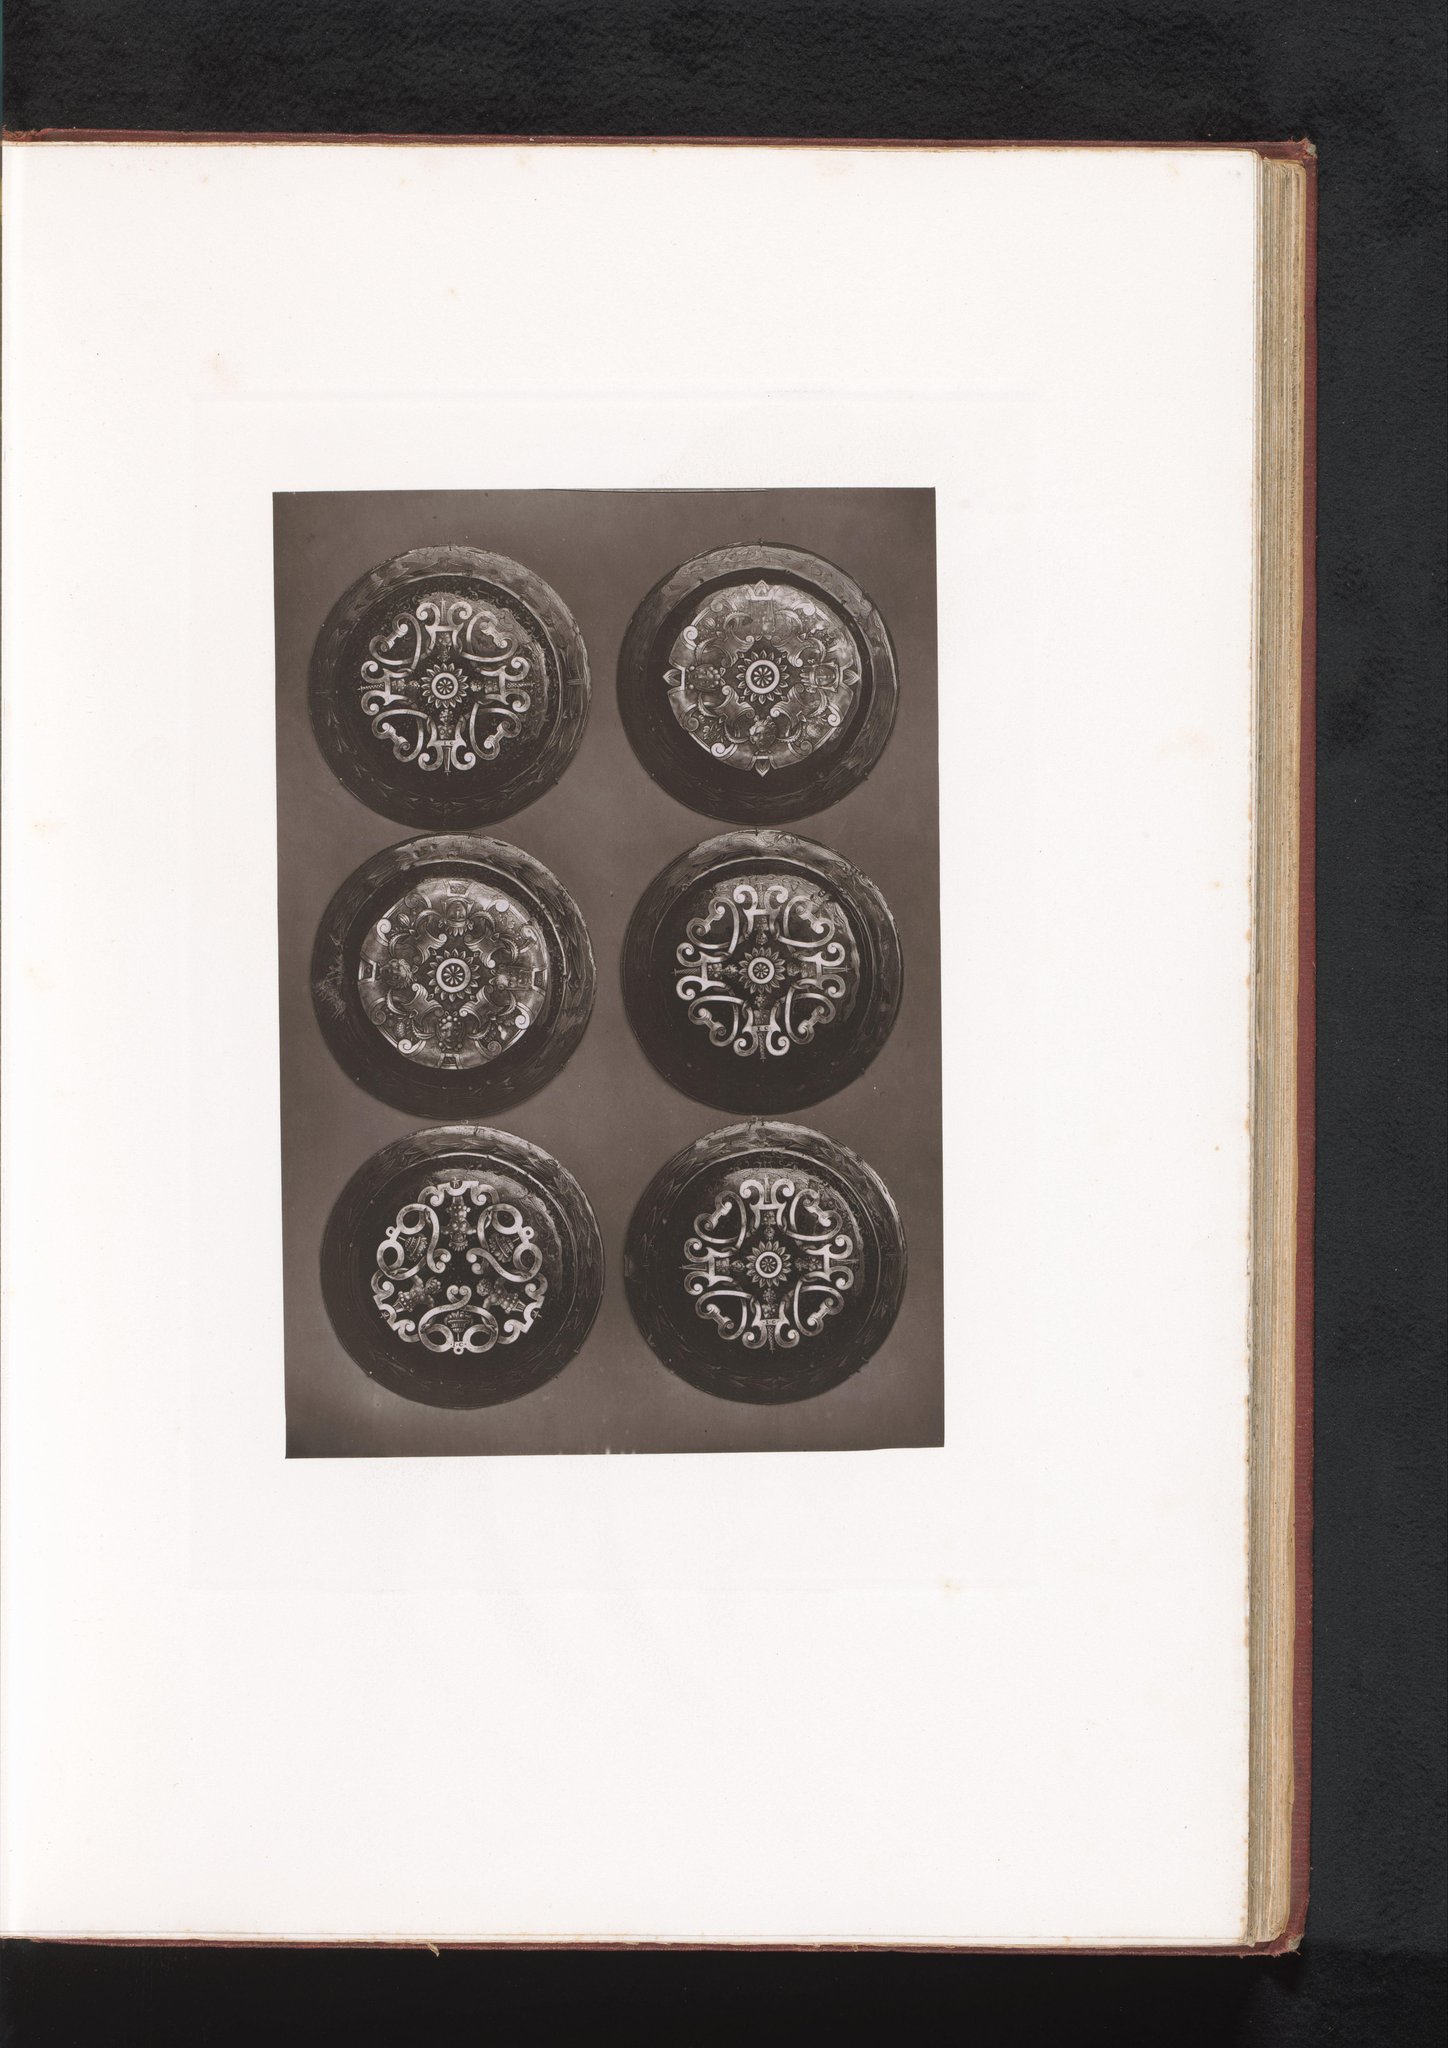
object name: page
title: Onderzijden van zes emaillen borden, opgesteld tijdens de Exposition Rétrospective van 1873 in Tours, Frankrijk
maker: gabriel blaise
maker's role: printer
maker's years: 1827-1897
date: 1873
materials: paper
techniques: woodburytype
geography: tours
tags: enamelling ~ applied arts, dish, plate, saucer, temporary exhibition, 'salon'